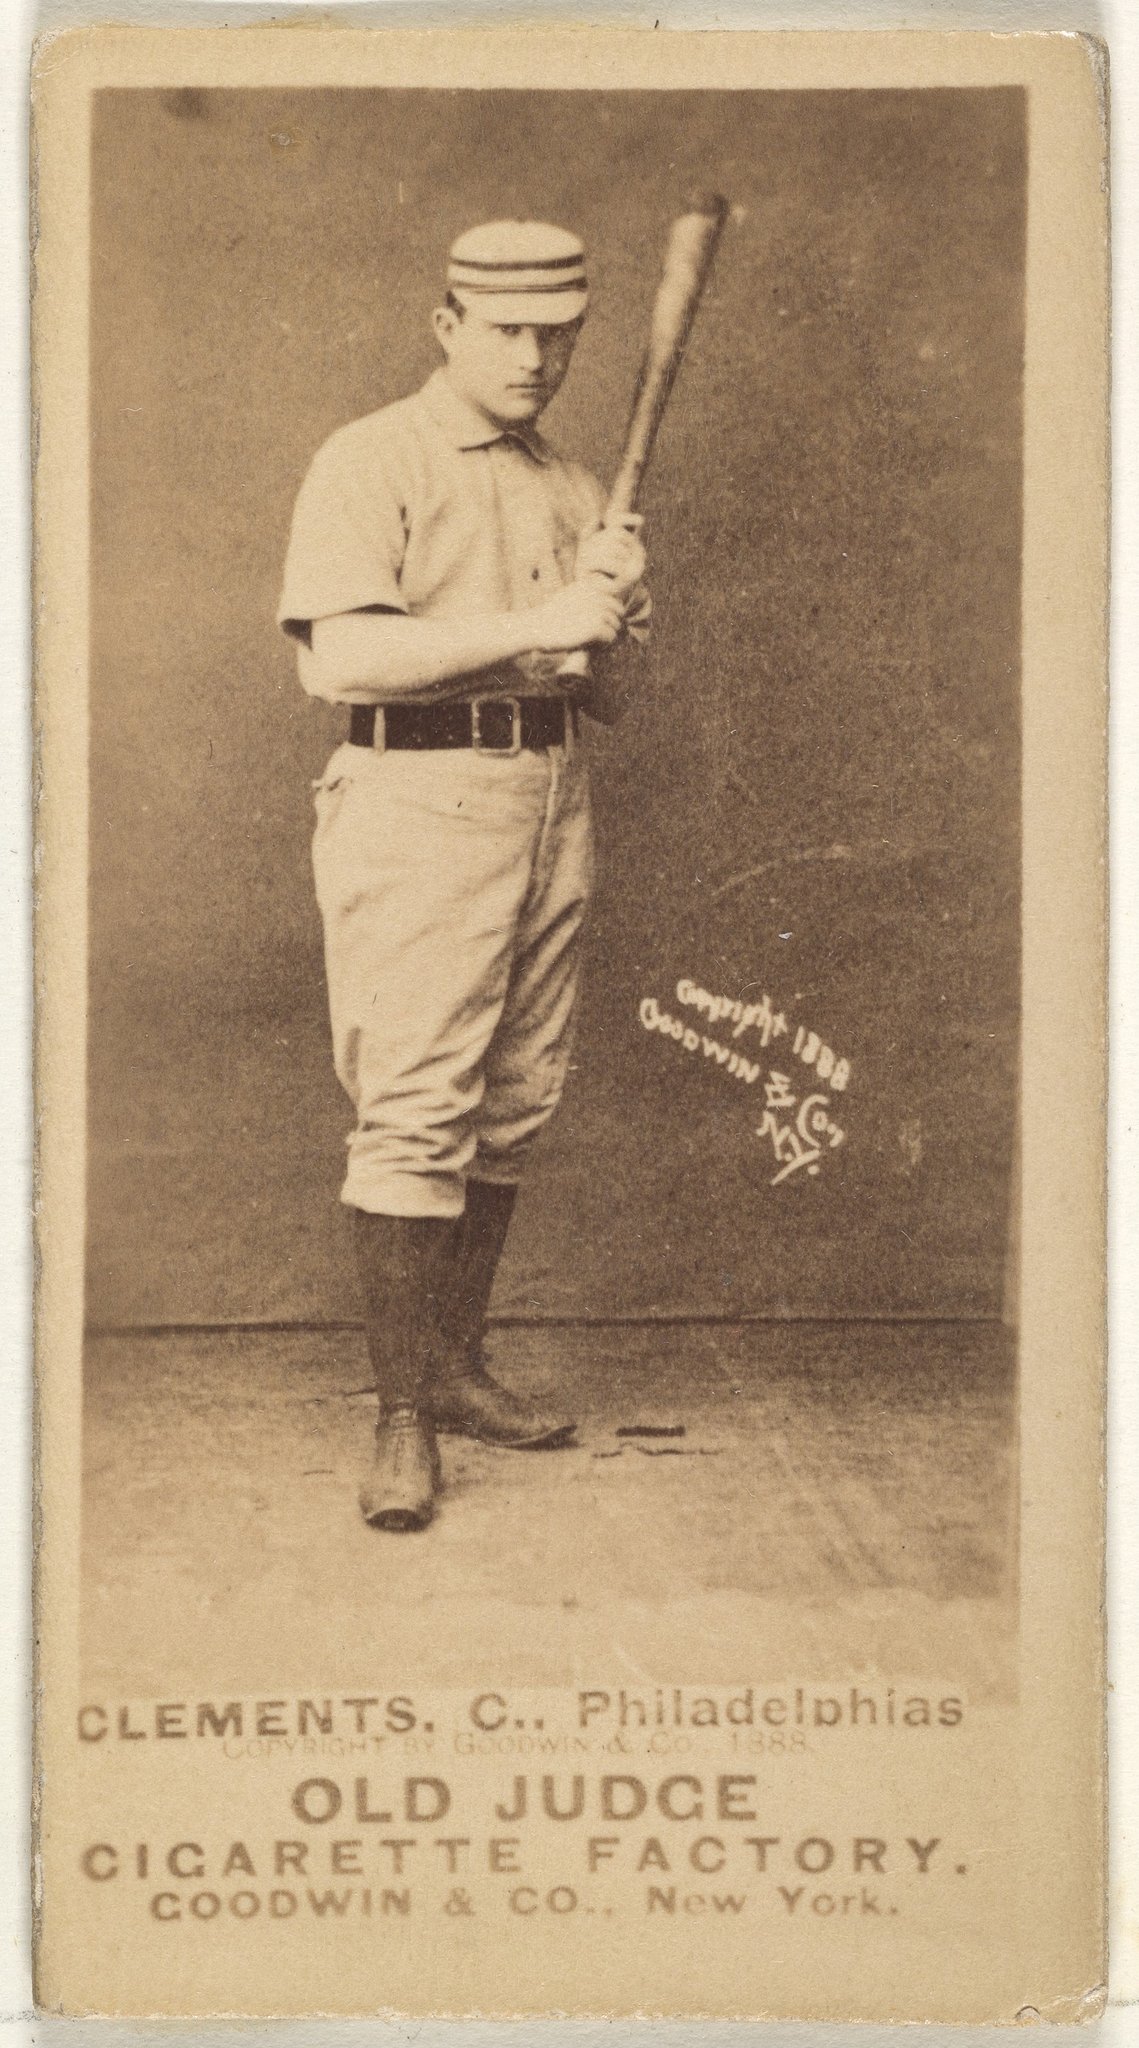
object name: baseball card, photograph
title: John J. "Jack" Clements, Catcher, Philadelphia, from the Old Judge series (N172) for Old Judge Cigarettes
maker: goodwin & company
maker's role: publisher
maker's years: 1850-1950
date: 1888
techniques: albumen silver print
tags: men,portraits,baseball,athletes